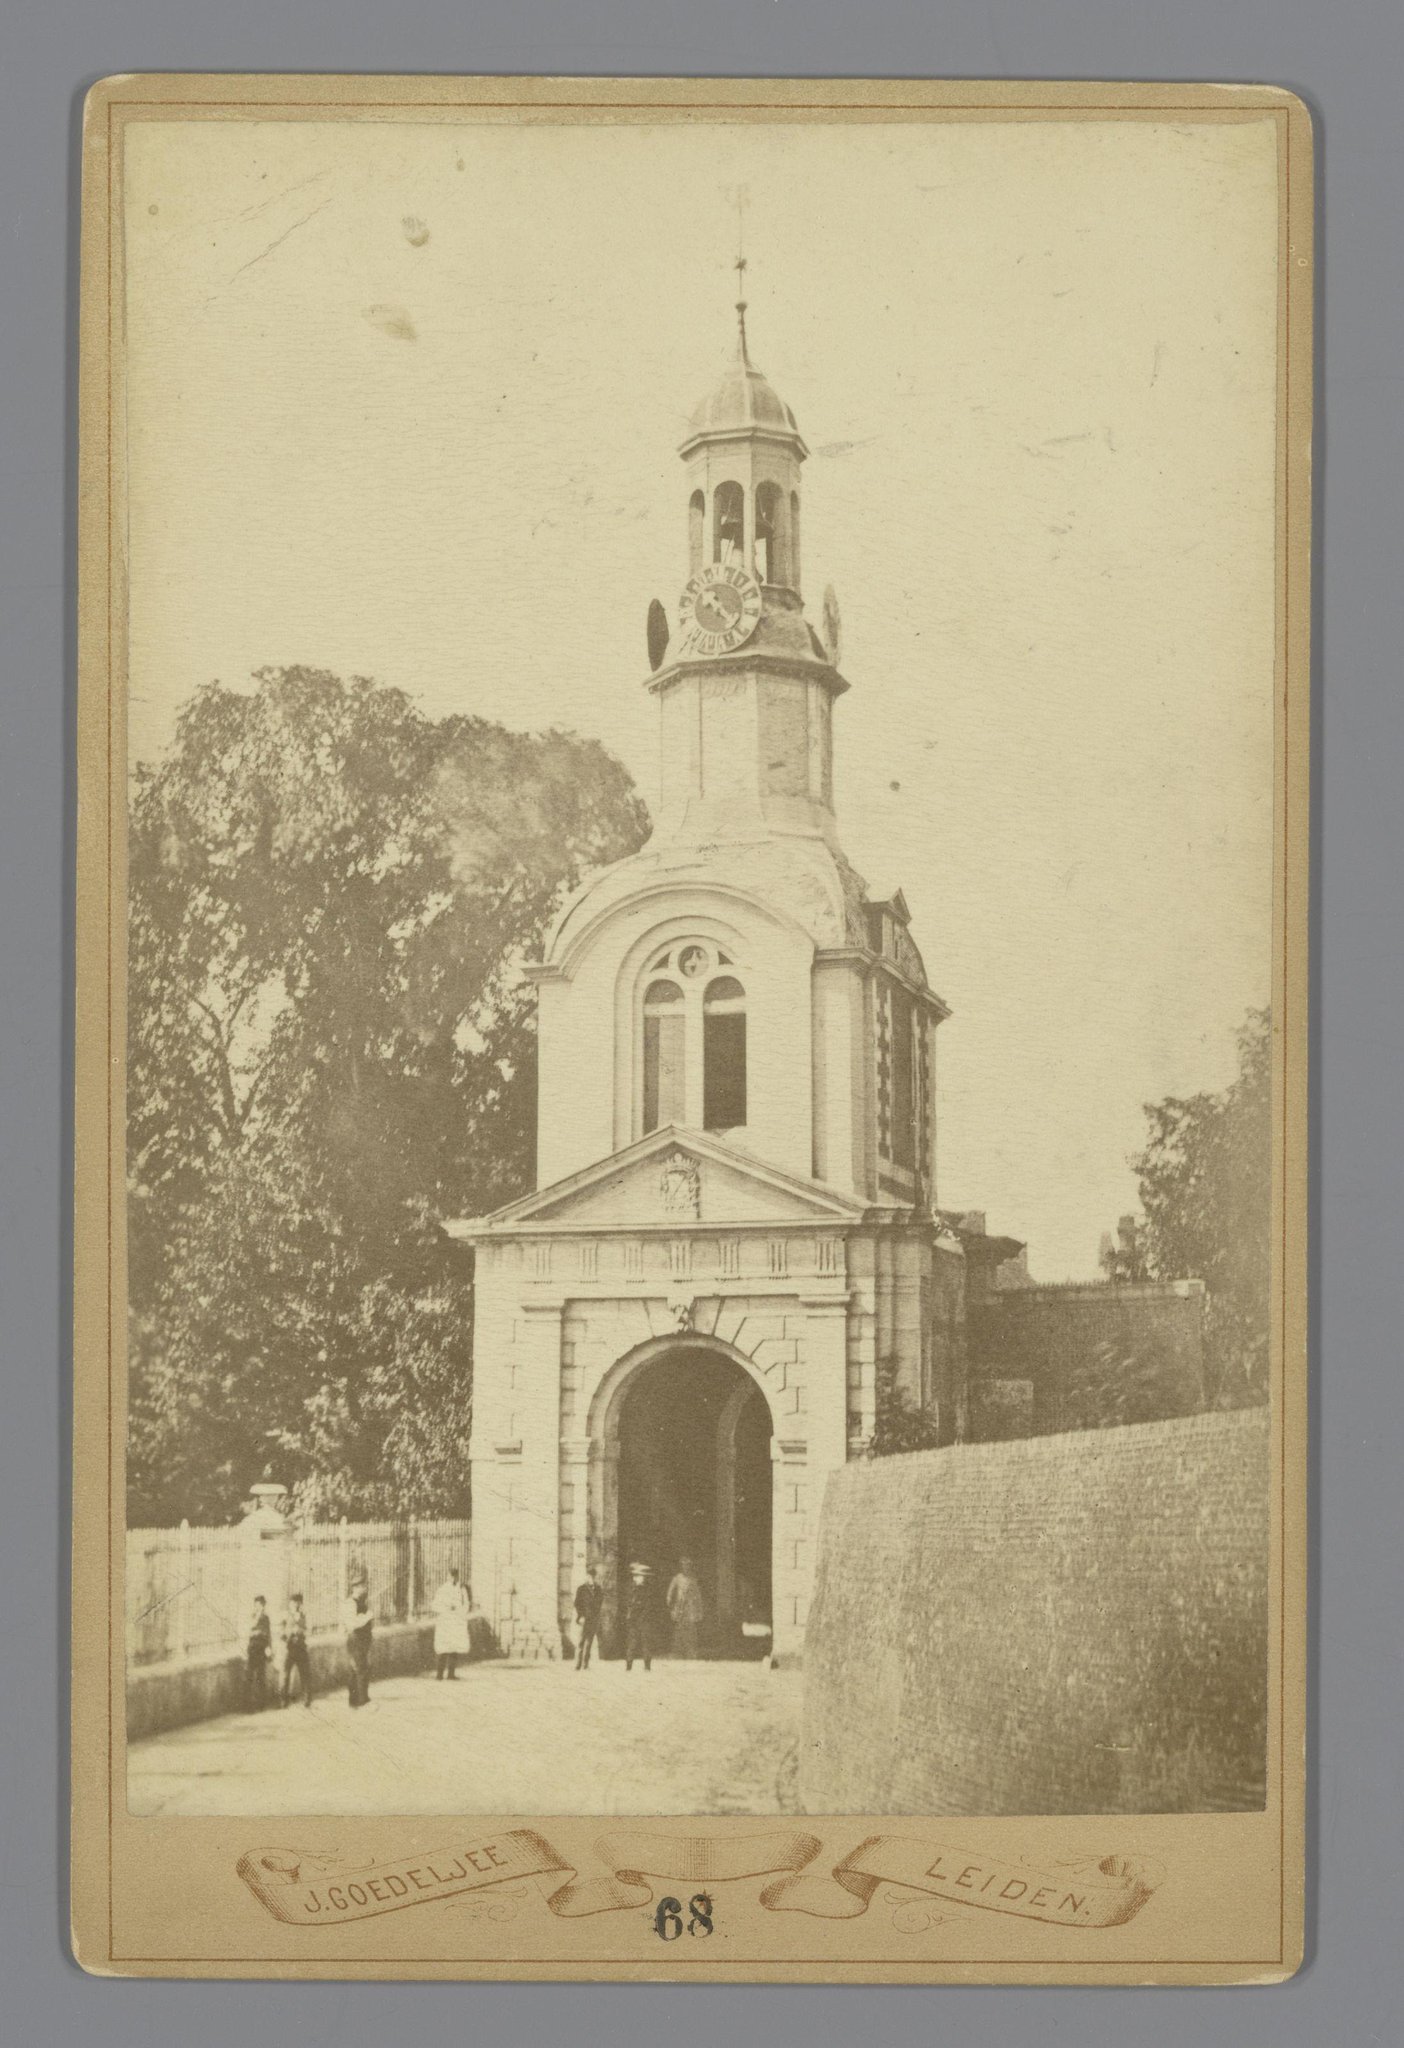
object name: photograph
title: Gezicht op de Hogewoerdspoort te Leiden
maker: jan goedeljee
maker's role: fotograaf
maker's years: 1824-1905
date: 1860-1876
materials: cardboard, photographic support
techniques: albumen print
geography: leiden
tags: city-gate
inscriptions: inscription: ‘J. Goedeljee (...) Leiden/ Hoogewoerd 160/ naby de Plantage’, annotation: ‘Hoogewoerdspoort’, inscription: ‘J. Goedeljee/ Leiden/ 68’